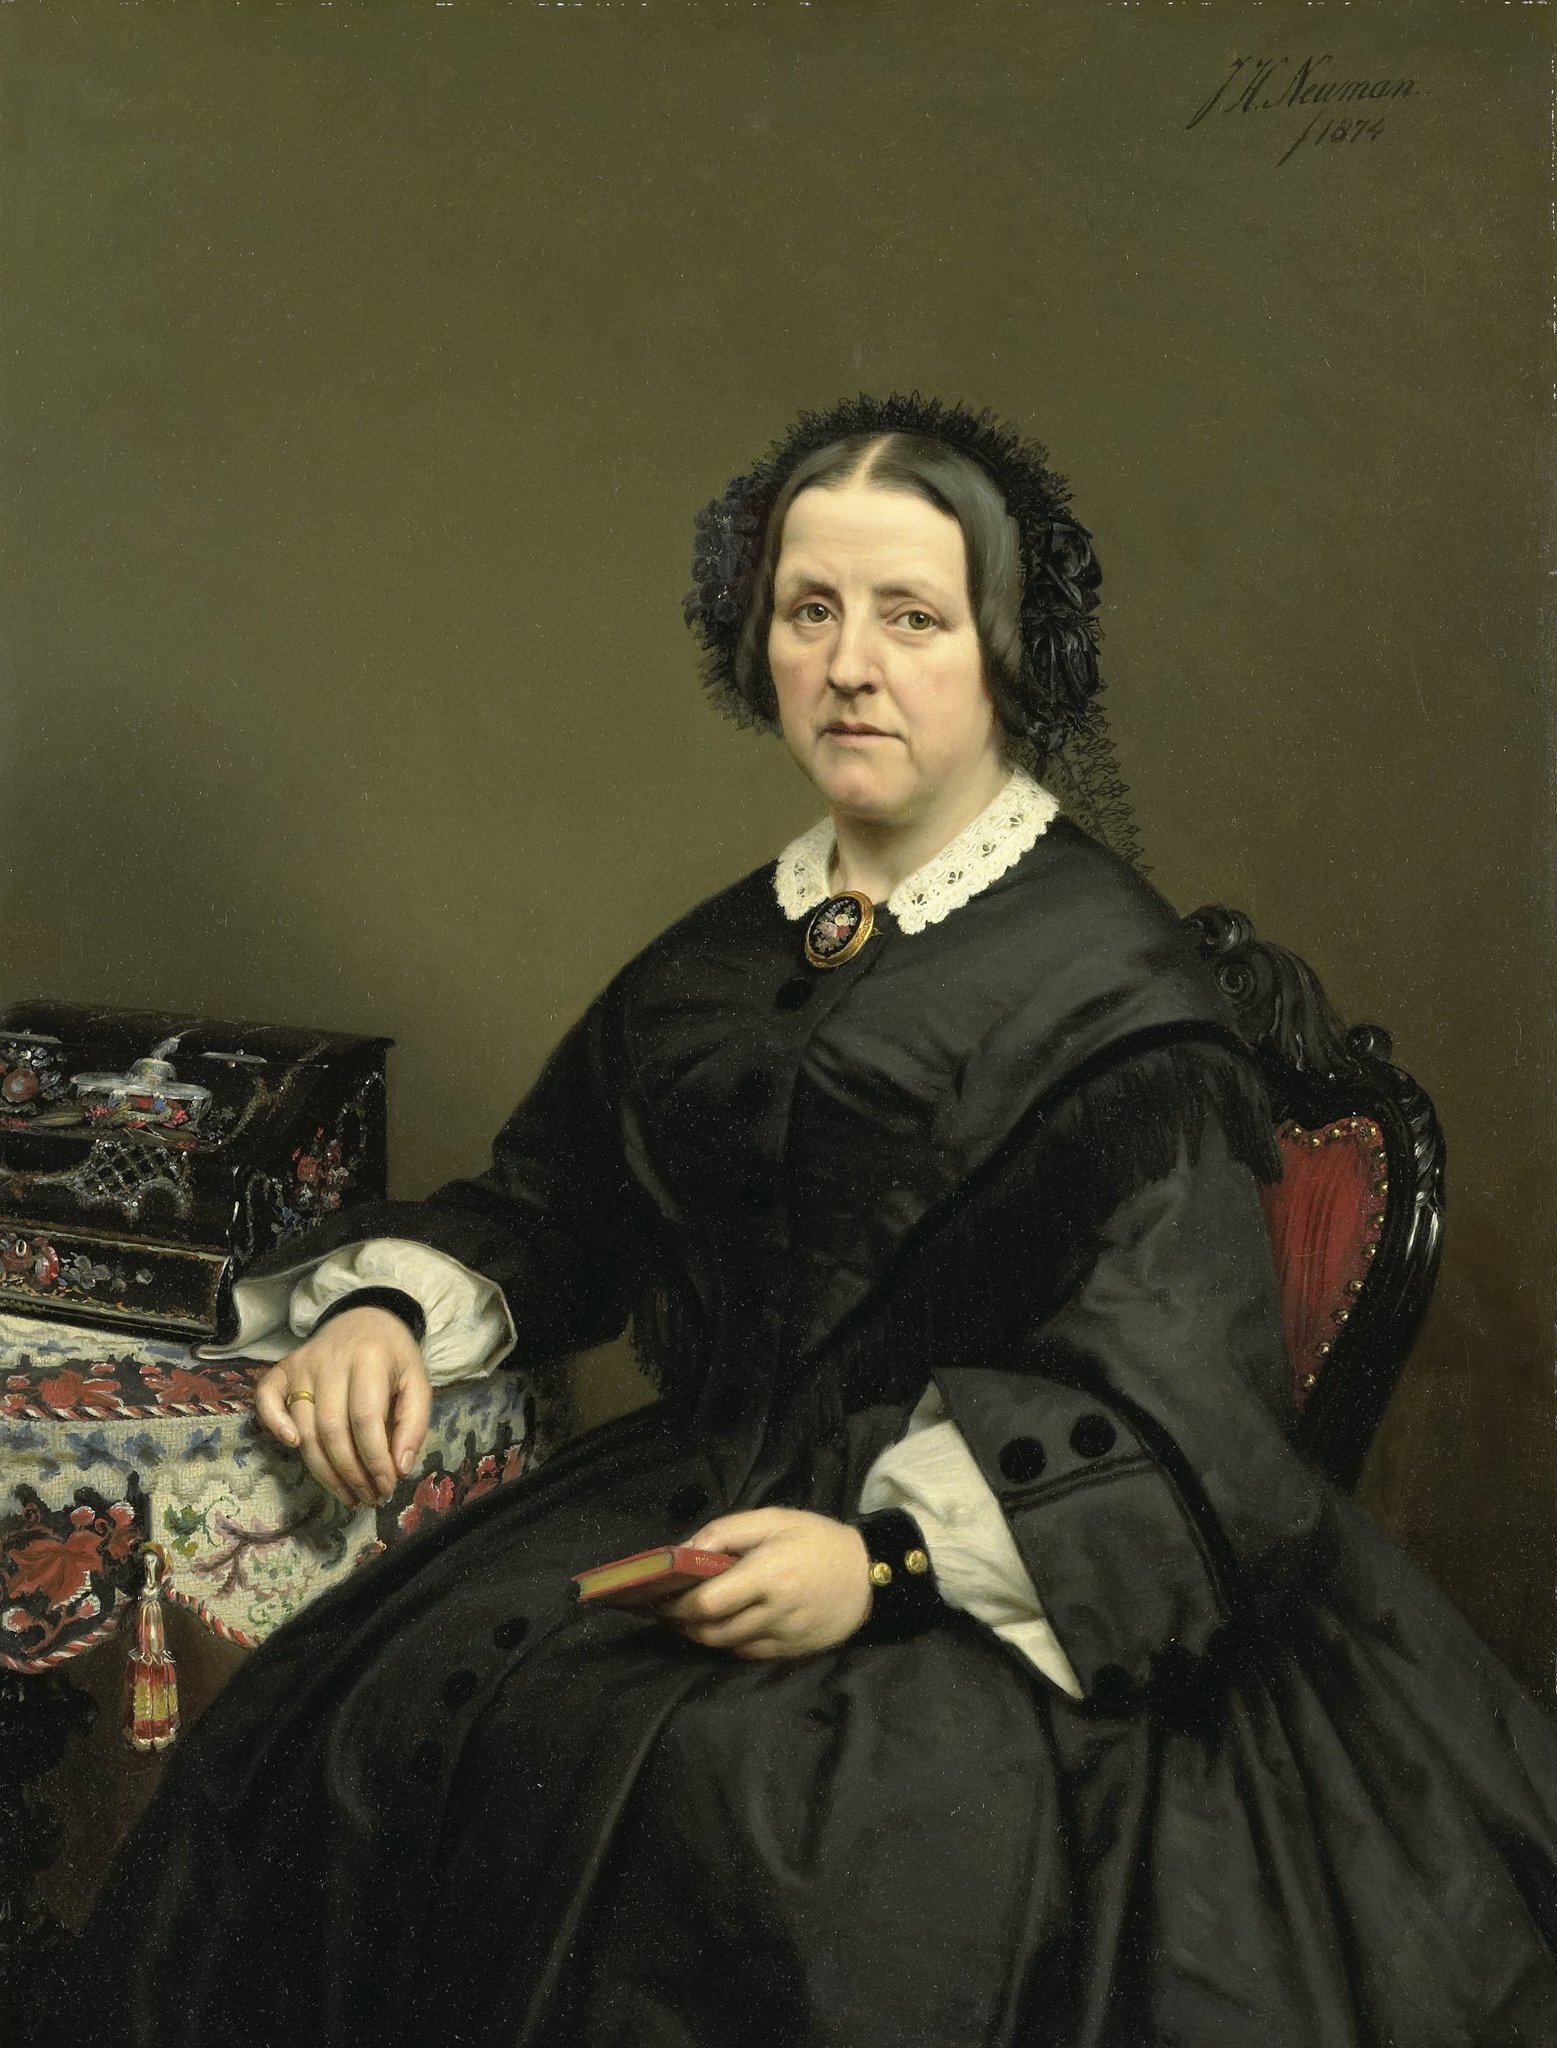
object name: painting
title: Wilhelmina Margaretha van den Bosch (1807-74). Echtgenote van Gerard Johan Verloren van Themaat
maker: johan heinrich neuman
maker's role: draughtsman, painter, print maker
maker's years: 1819-1898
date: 1874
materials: canvas, oil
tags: historical persons - bb - woman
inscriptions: signature and date: ‘J. H. Neuman. f 1874’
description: Portret van Wilhelmina Margaretha van den Bosch (1807-74). Echtgenote van Gerard Johan Verloren van Themaat. Kniestuk, zittende in een stoel met een boekje in de linkerhand. Pendant van SK-A-2824.